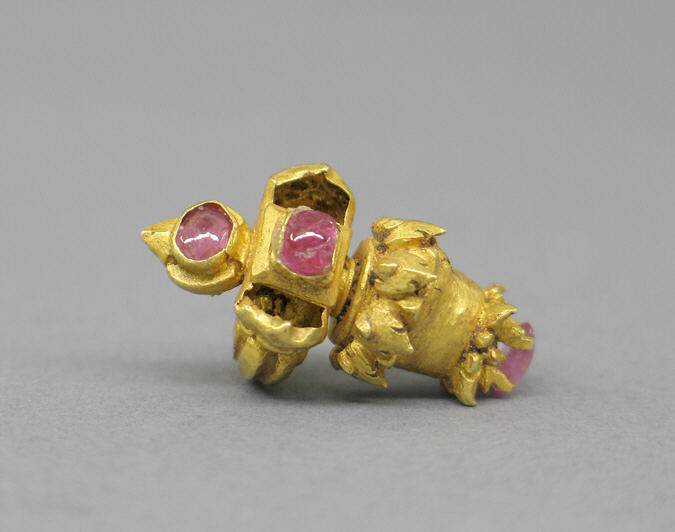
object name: ear clip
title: Ear Clip with Opaline Stones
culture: indonesian, javanese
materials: gold, stone